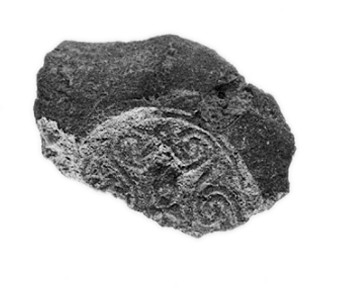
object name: sealing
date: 1981-1640 BCE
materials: mud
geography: egypt